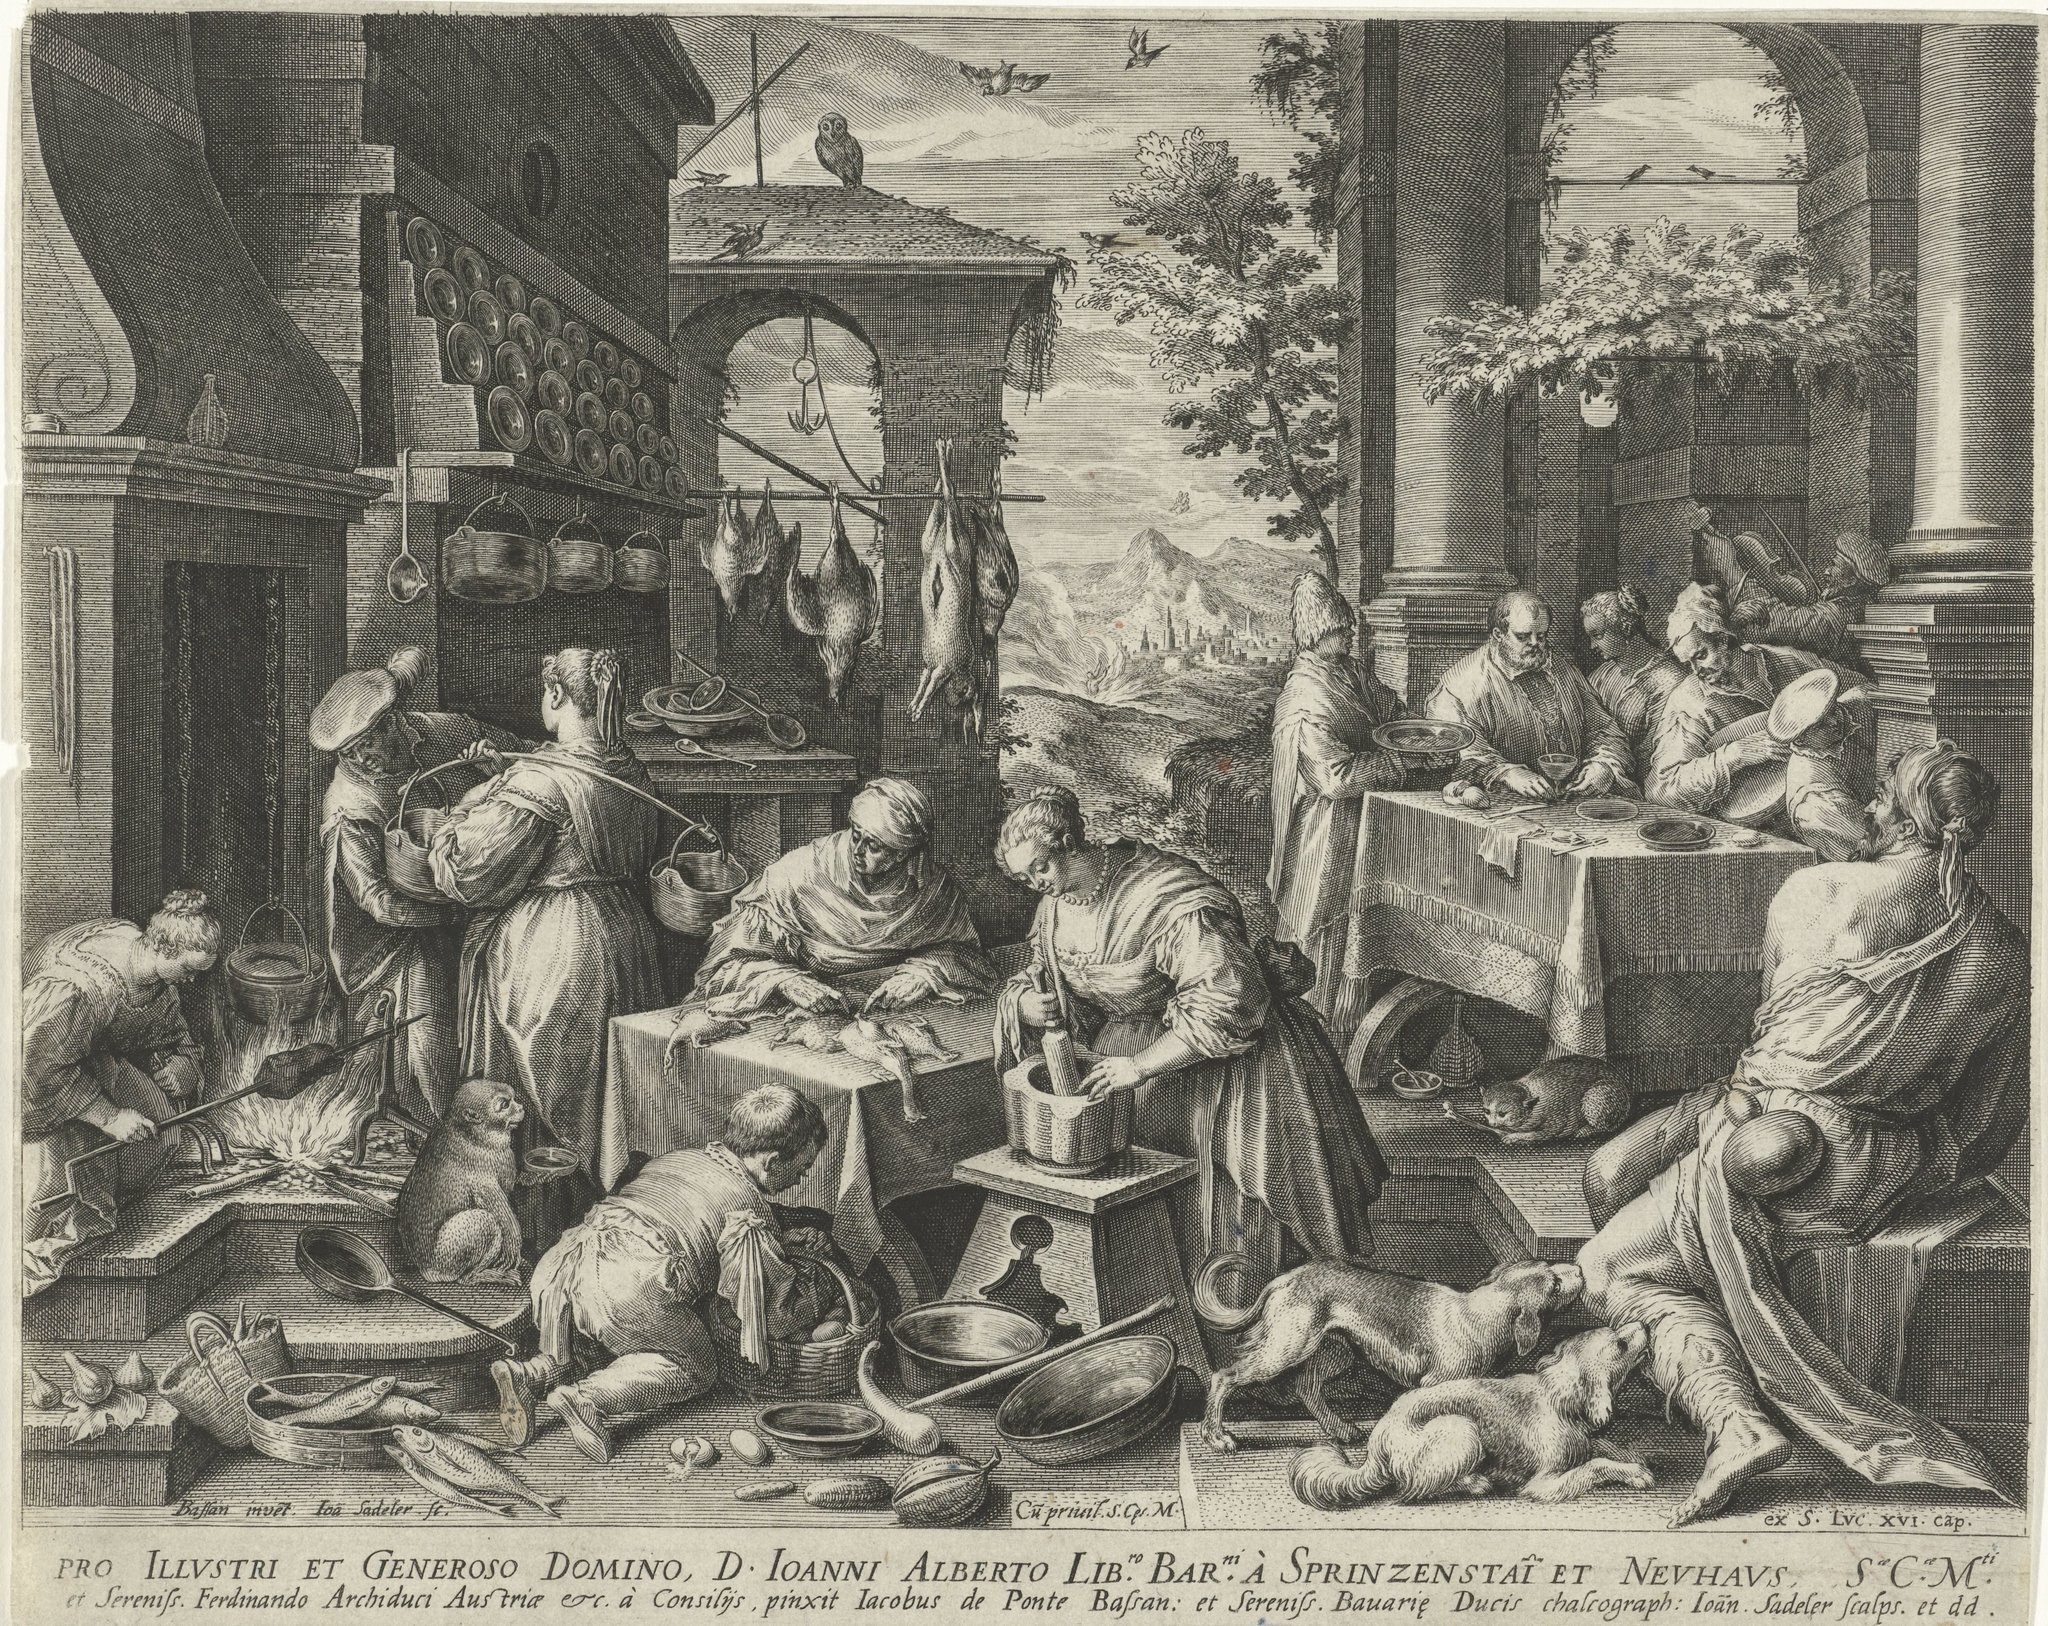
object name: print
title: Keukenstukken naar Jacopo Bassano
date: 1593-1598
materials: paper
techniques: engraving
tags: kitchen, the rich man (dives) is feasting, while poor lazarus is starving at the gate (dogs licking lazarus' sores) (luke 16:19-31), kitchen-interior with foodstuffs in foreground (dutch: 'keukenstuk')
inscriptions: collector's mark: Lugt 240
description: Interieur van een buitenkeuken waar links een kip aan het spit wordt gebraden. In het midden een tafel waar gevogelte wordt bereid. Op de voorgrond rechts ligt de arme Lazarus te bedelen.Twee honden likken zijn wonden. Rechtsachter zit de rijke man aan de maaltijd. De tweede prent van een driedelige serie.